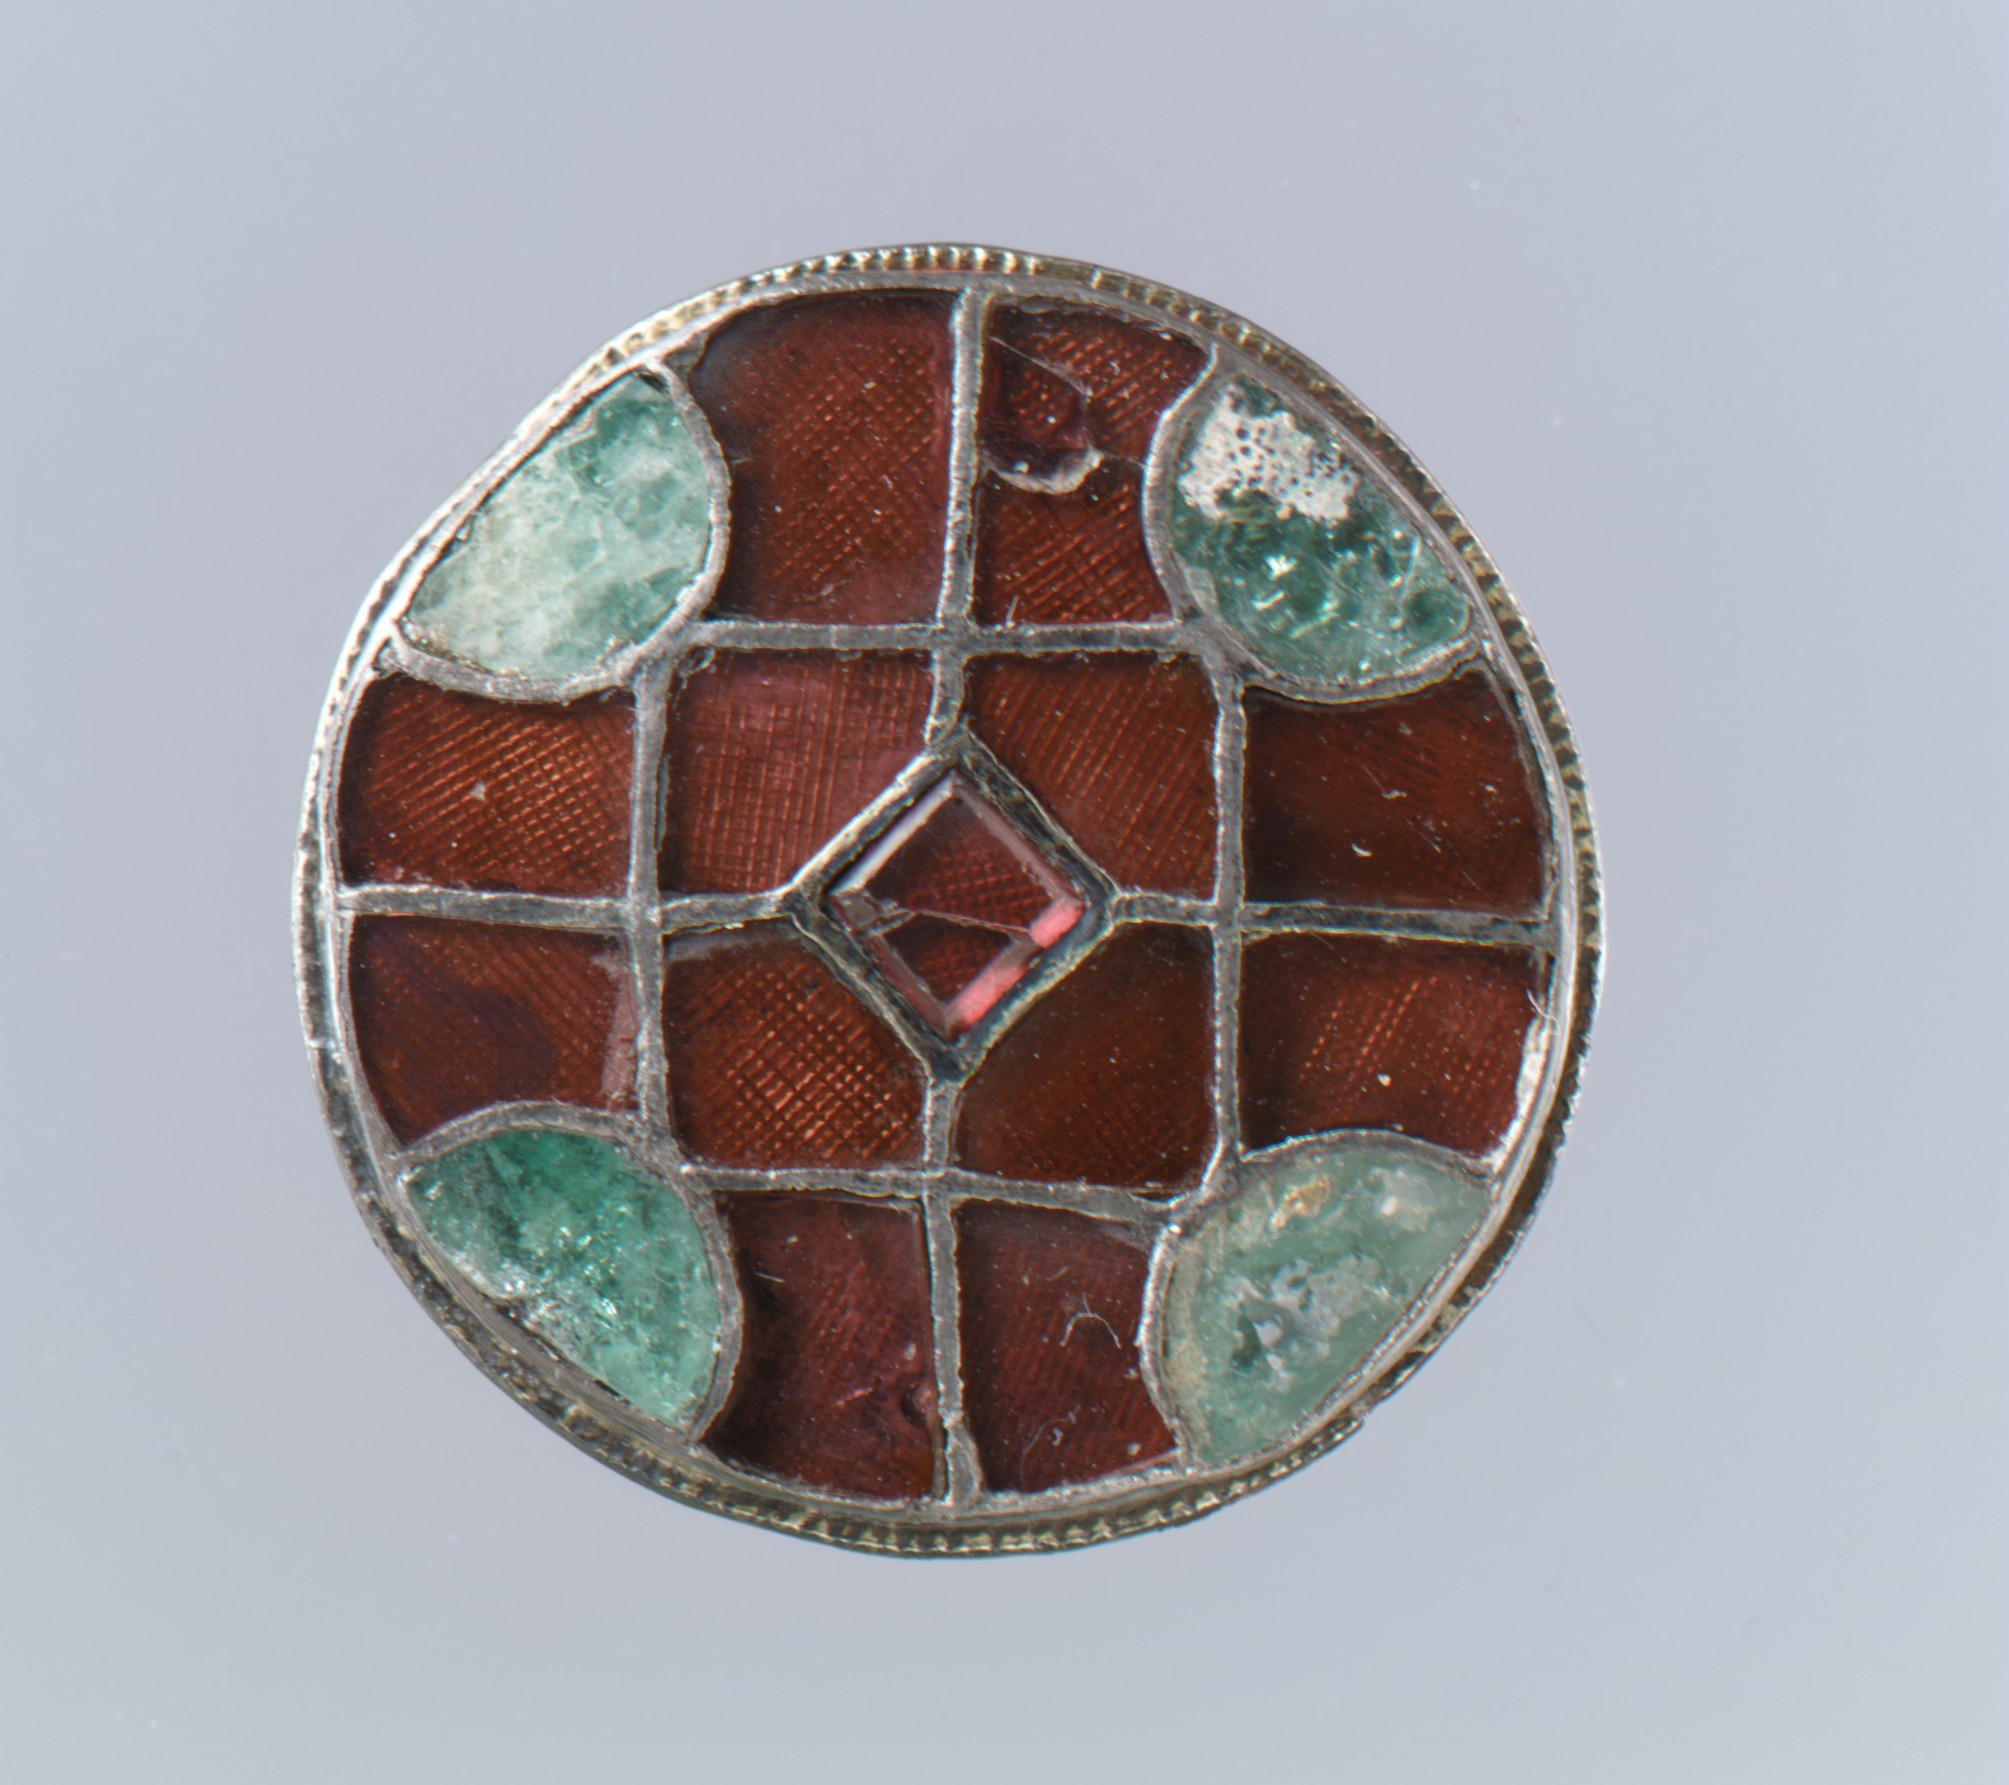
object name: brooch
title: Disk Brooch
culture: frankish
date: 501-600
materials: gemstone, foil, garnet, gilt, silver